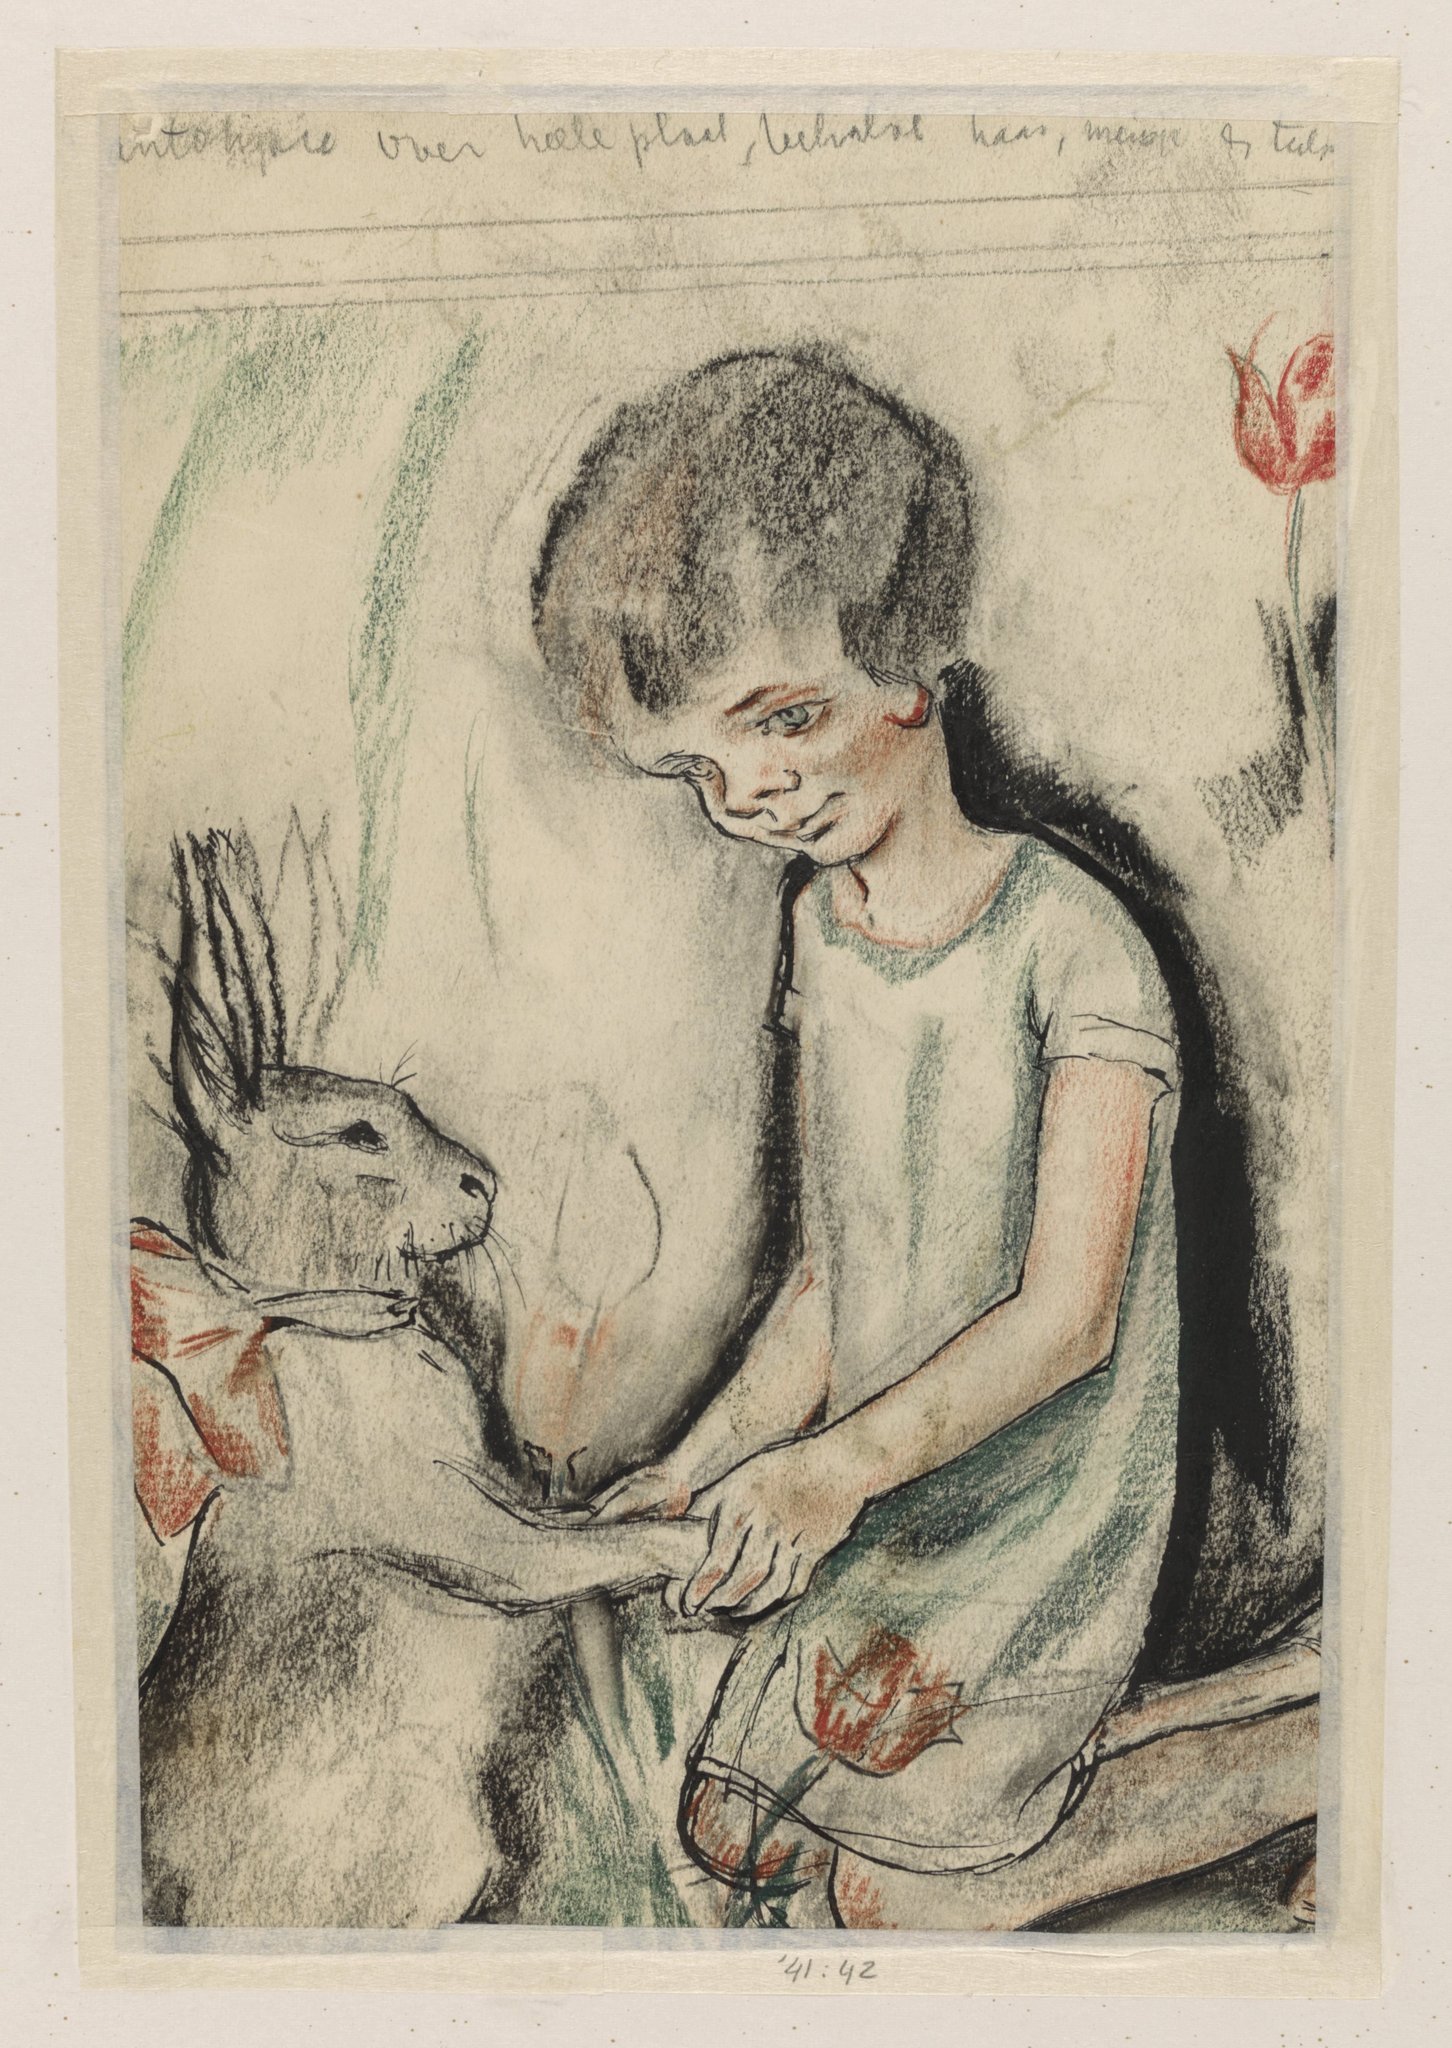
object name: drawing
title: Knielend meisje houdt een haas vast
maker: albert funke küpper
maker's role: draughtsman, print maker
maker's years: 1894-1934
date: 1904-1934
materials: chalk, ink, paper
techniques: pen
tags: rodents: hare, girl (child between toddler and youth), kneeling on both knees